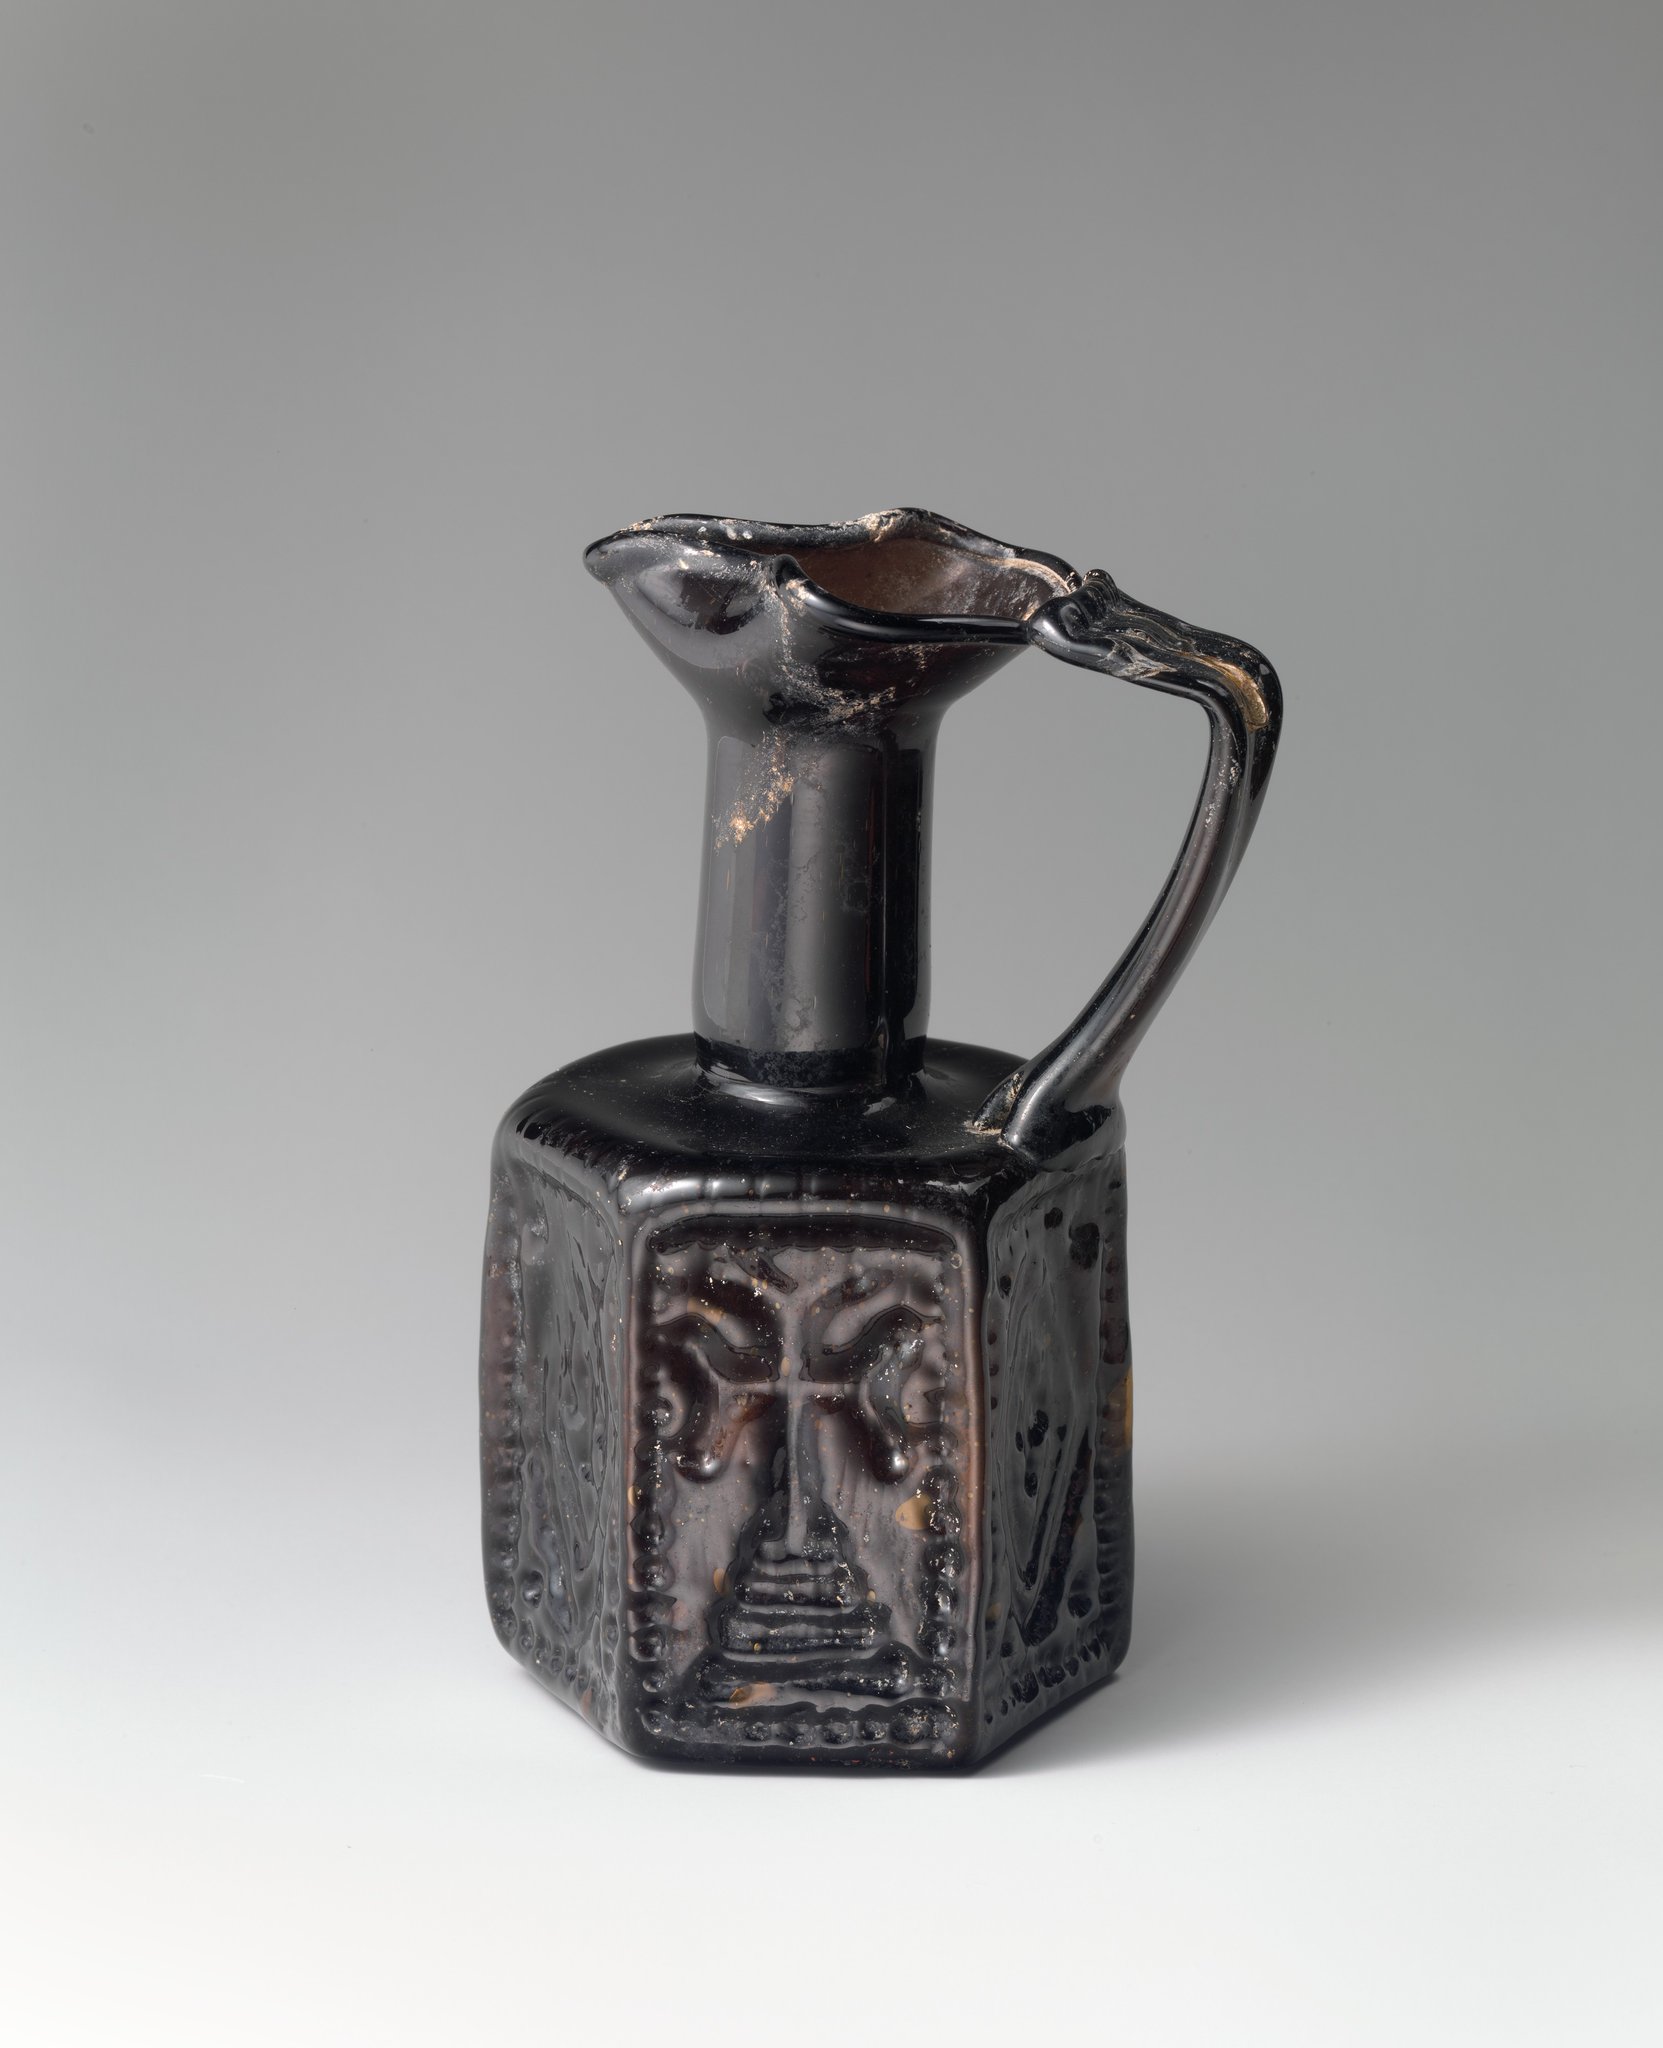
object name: jug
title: Hexagonal Jug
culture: byzantine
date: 501-666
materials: glass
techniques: molding